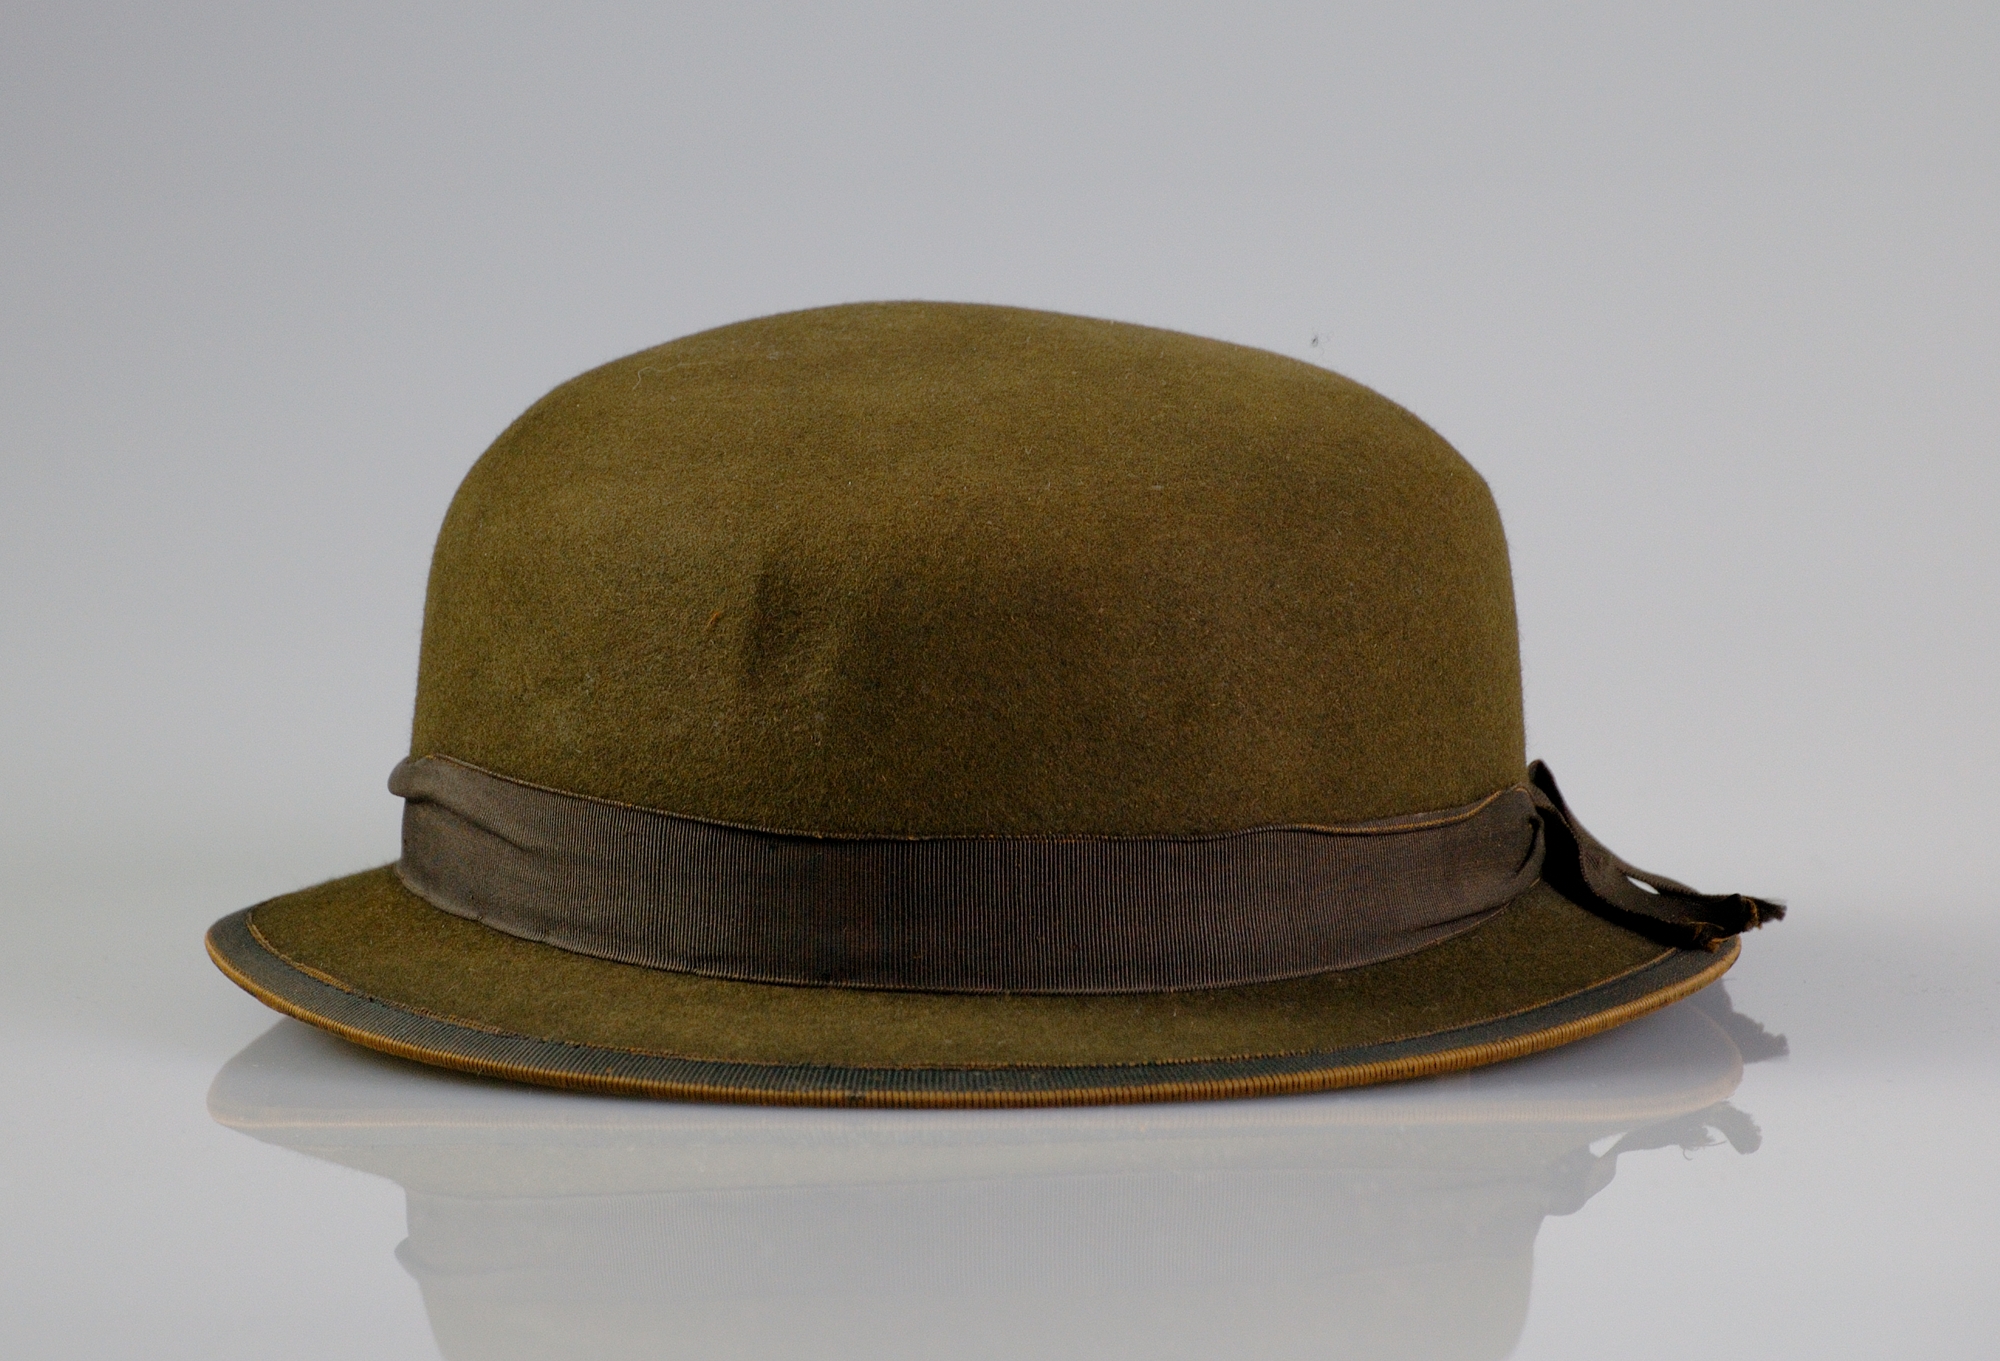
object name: hat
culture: american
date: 1870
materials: silk, wool